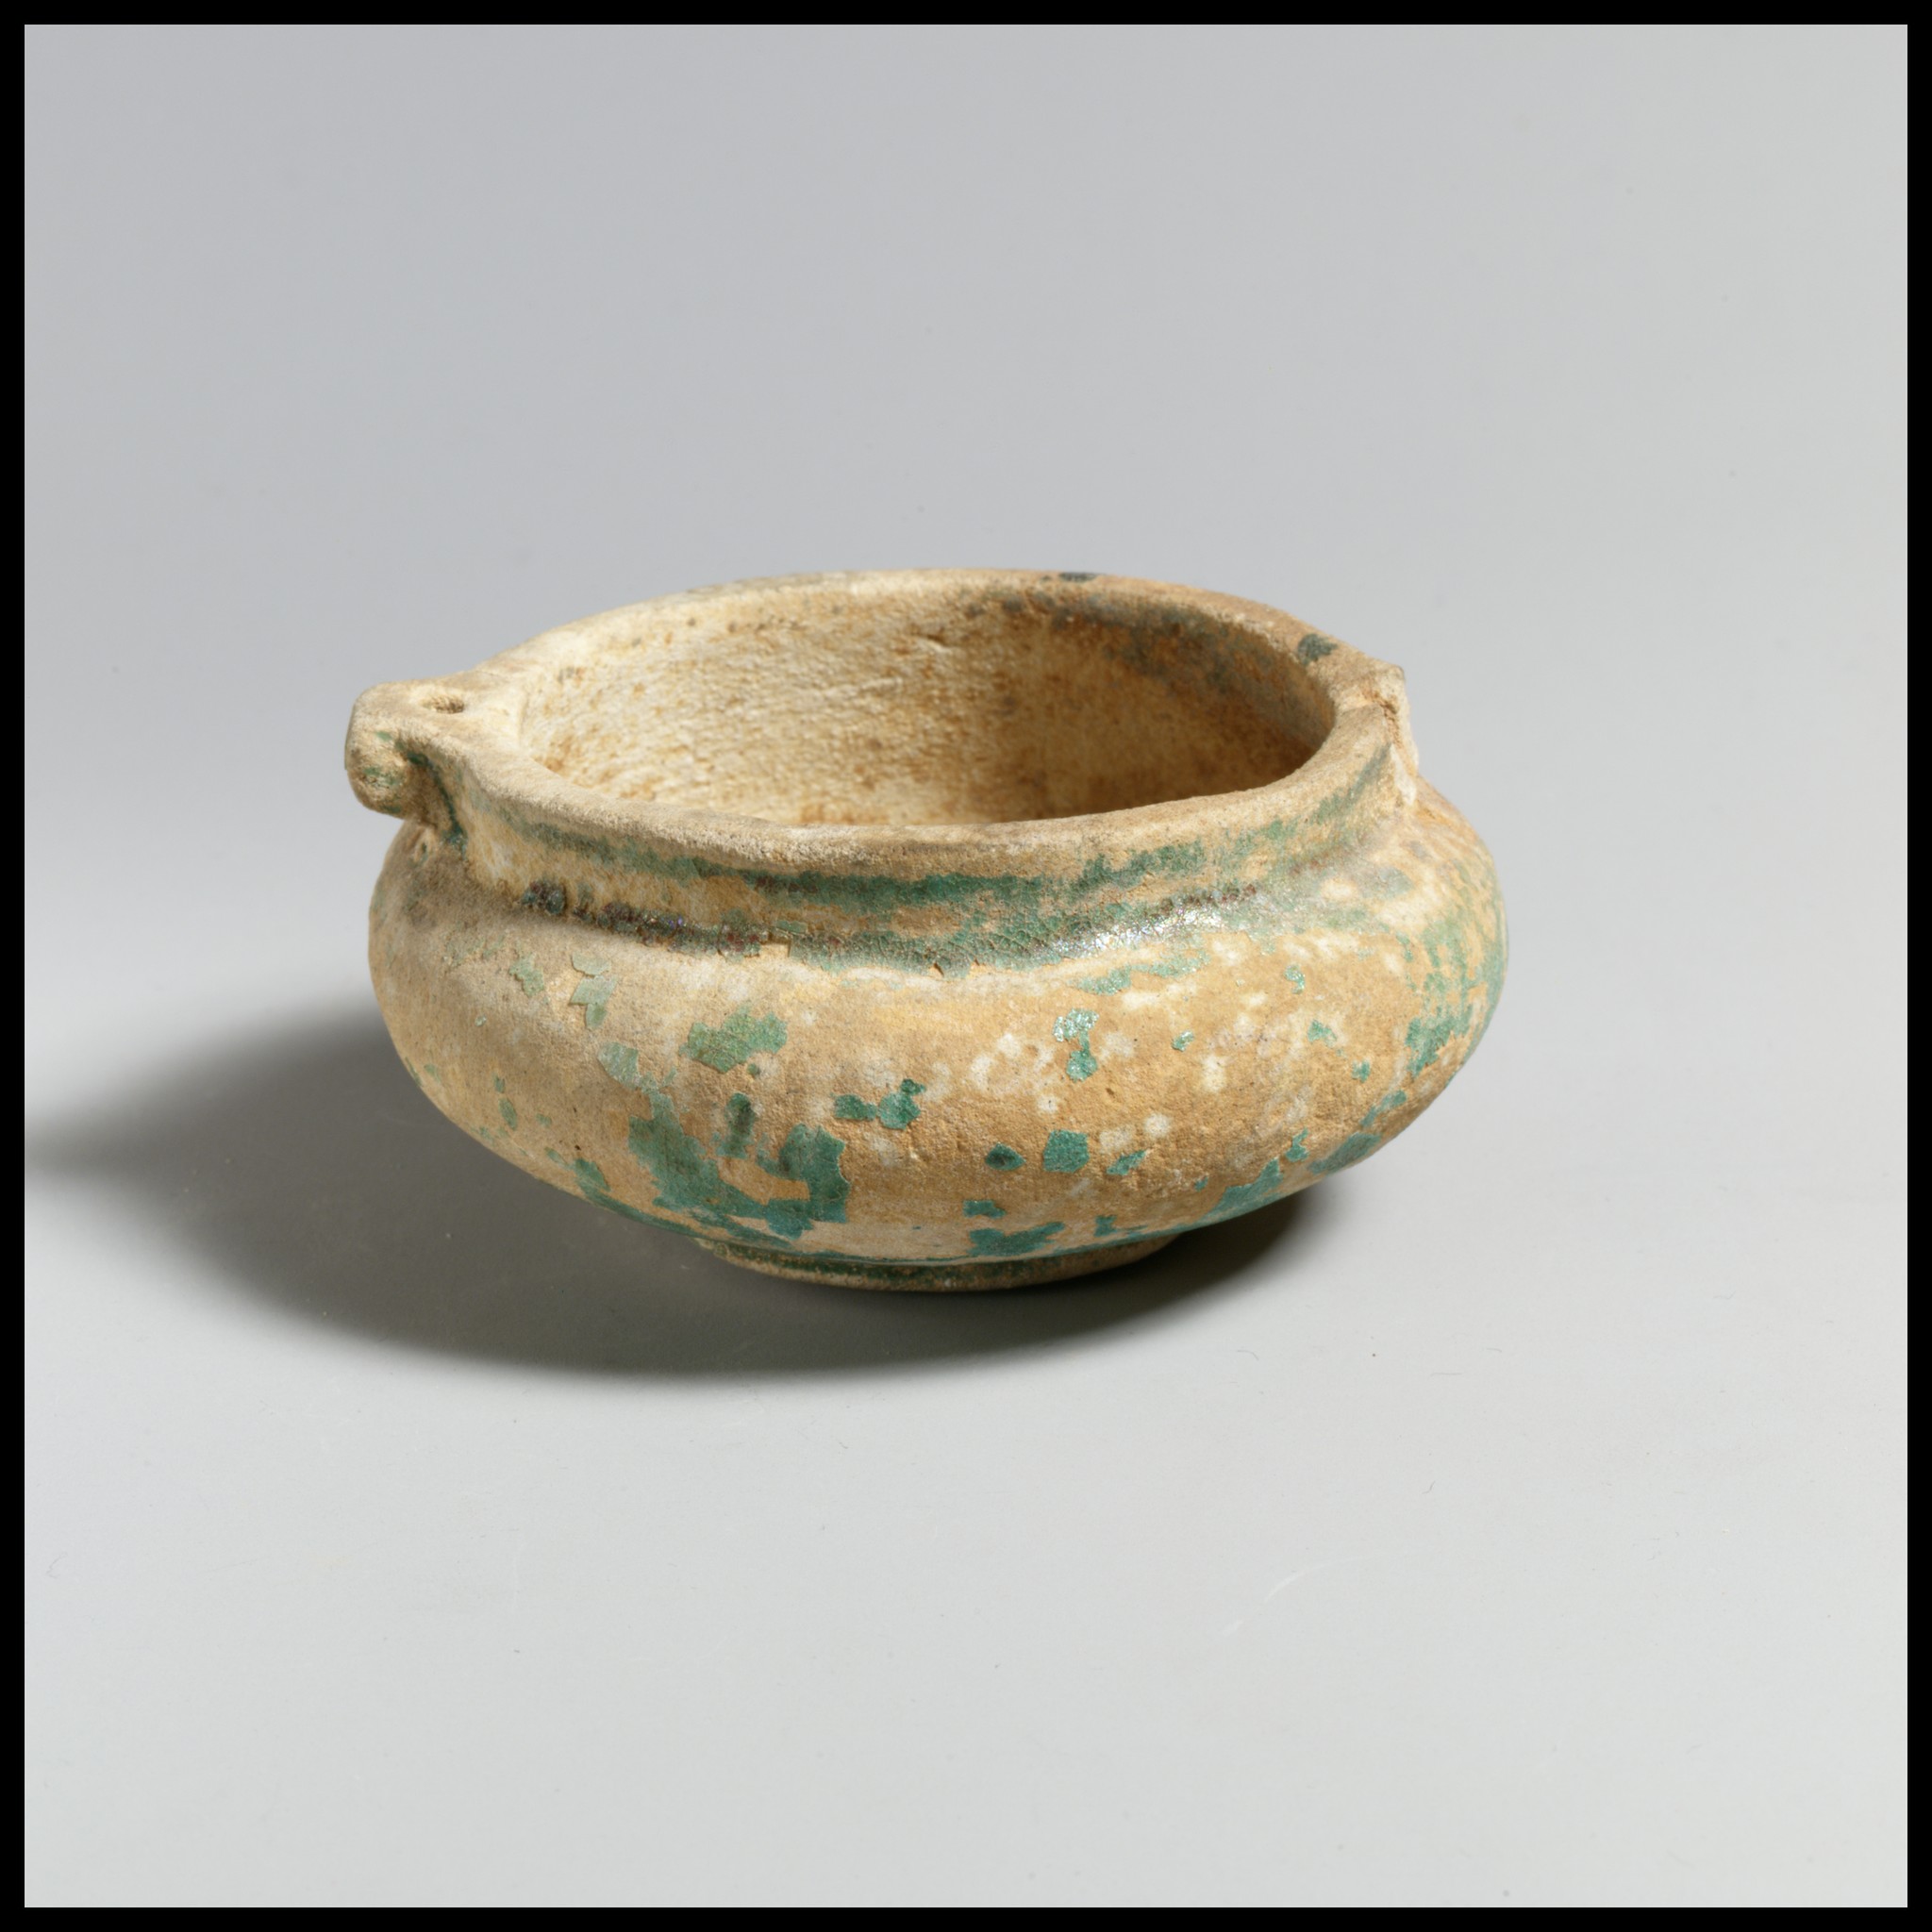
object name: bowl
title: Faience pyxis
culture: cypriot or levantine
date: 1300-1101 BCE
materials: faience